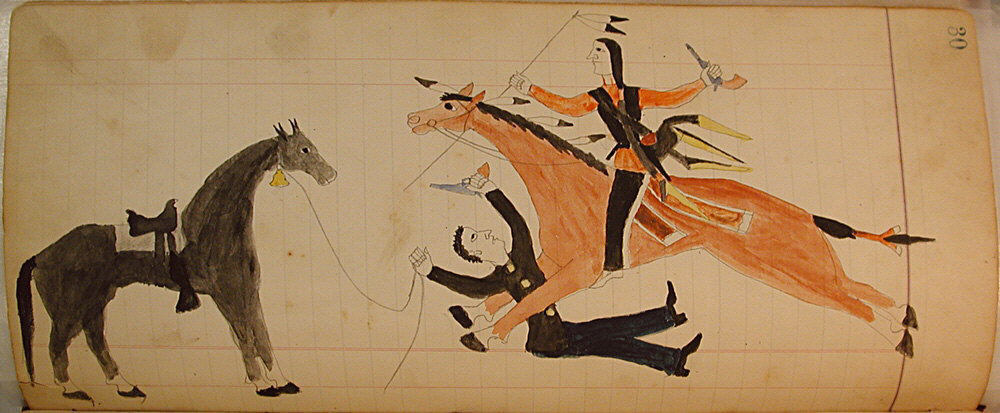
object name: drawing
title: Maffet Ledger: Indian on horseback, man dismounted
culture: cheyenne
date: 1874-1881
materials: crayon, graphite, paper, watercolor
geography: united states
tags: weapons,firearms,men,horses